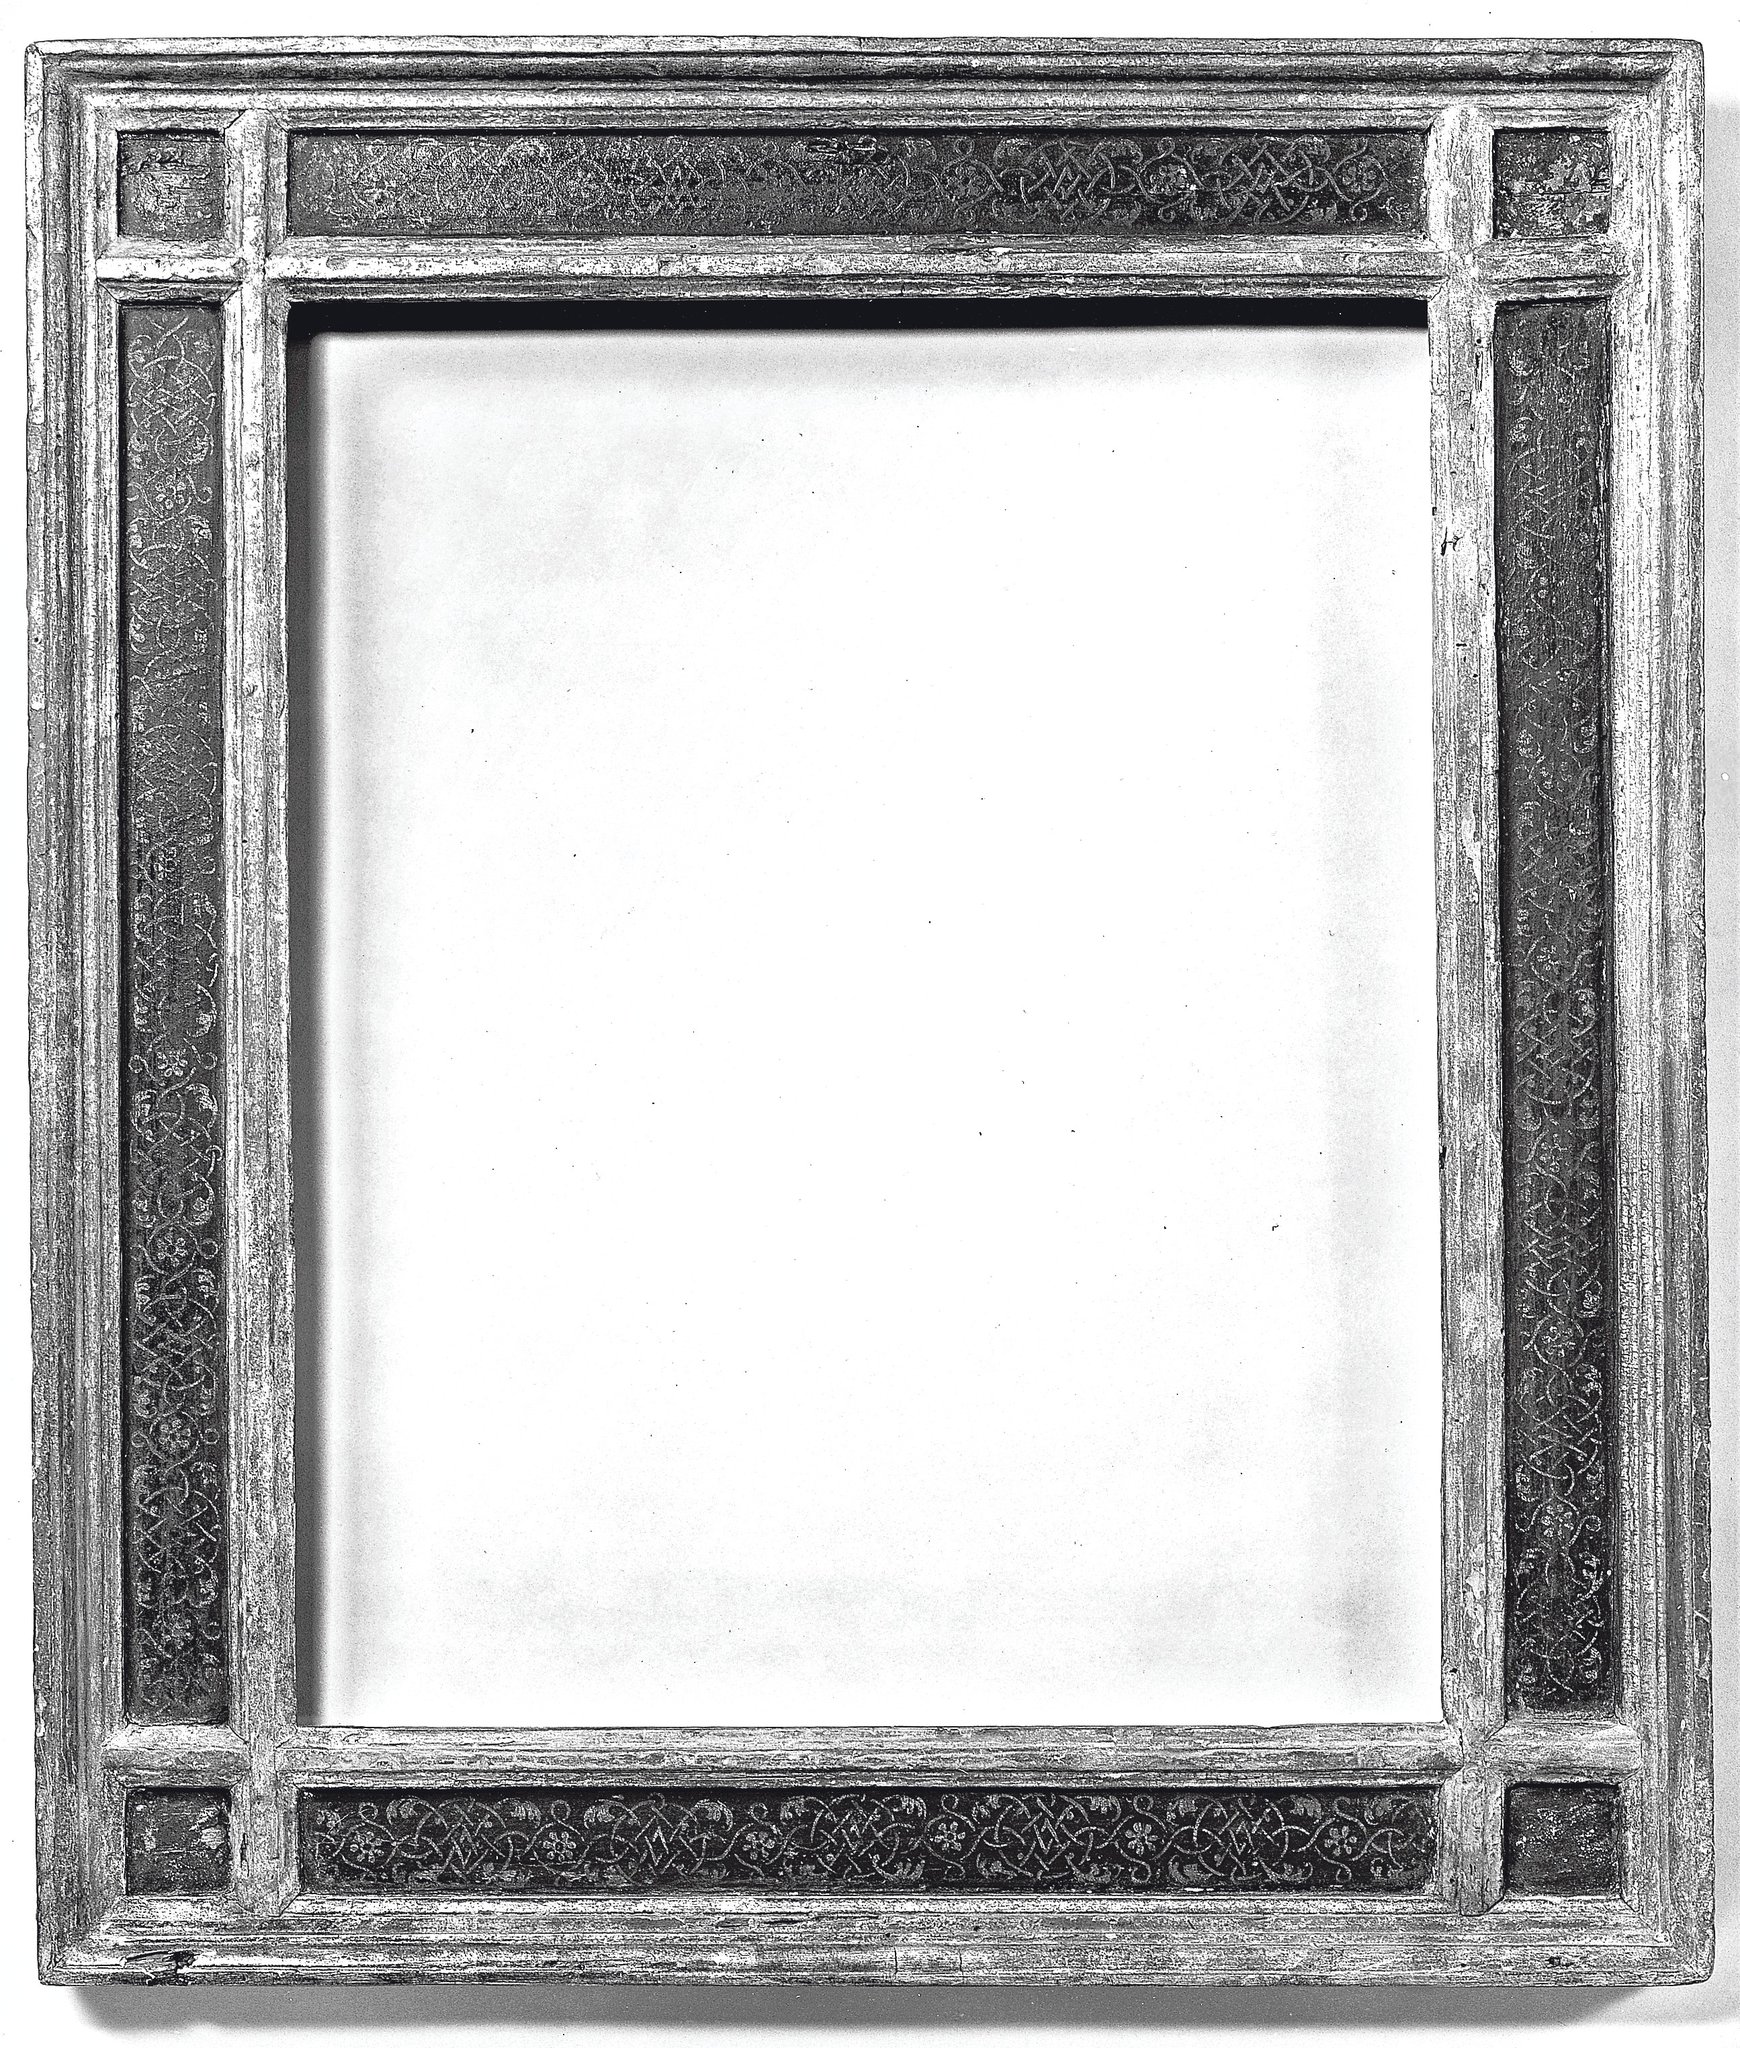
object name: frame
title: Cassetta frame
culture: italian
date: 1501-1533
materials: wood